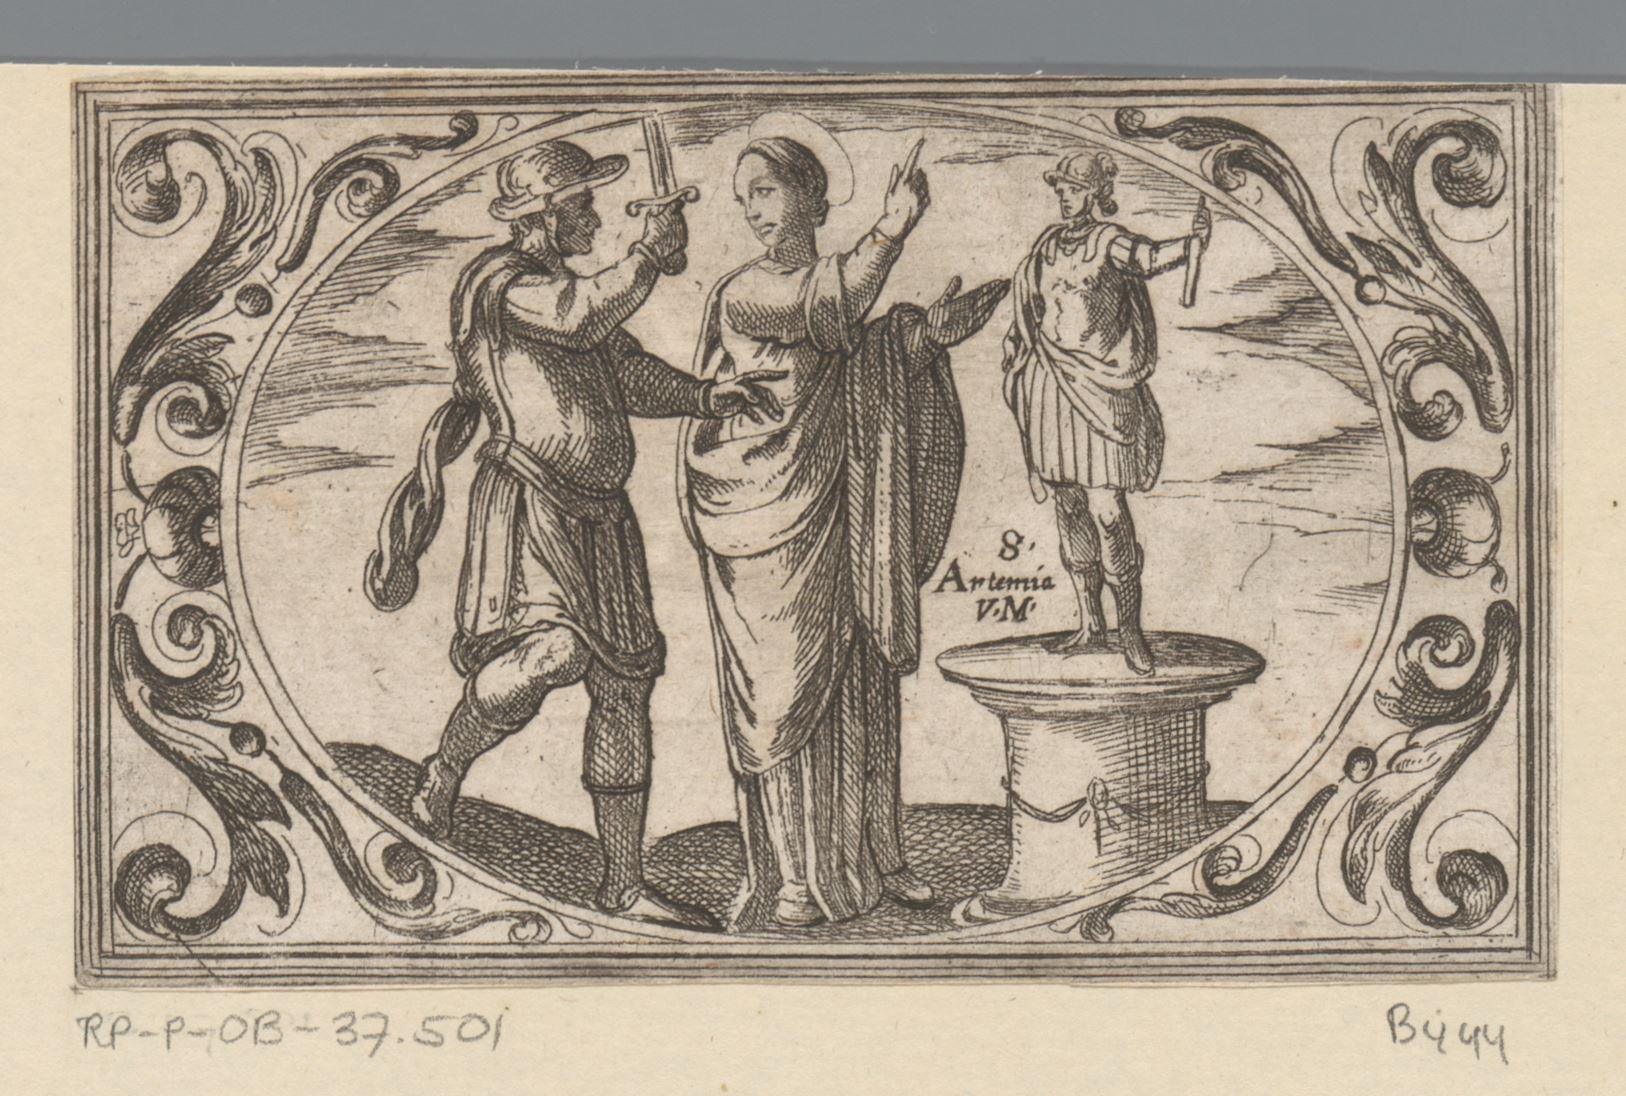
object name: print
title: Imagini di moltes vergini Rom nel martirio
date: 1565-1630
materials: paper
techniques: etching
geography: vatican city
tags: martyr(s) (often with palm-branches) - qq - female martyr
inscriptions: collector's mark: Lugt 240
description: Deze prent maakt deel uit van een reeks van 73 prenten (+ titelprent) met voorstellingen van Romeinse martelaressen.